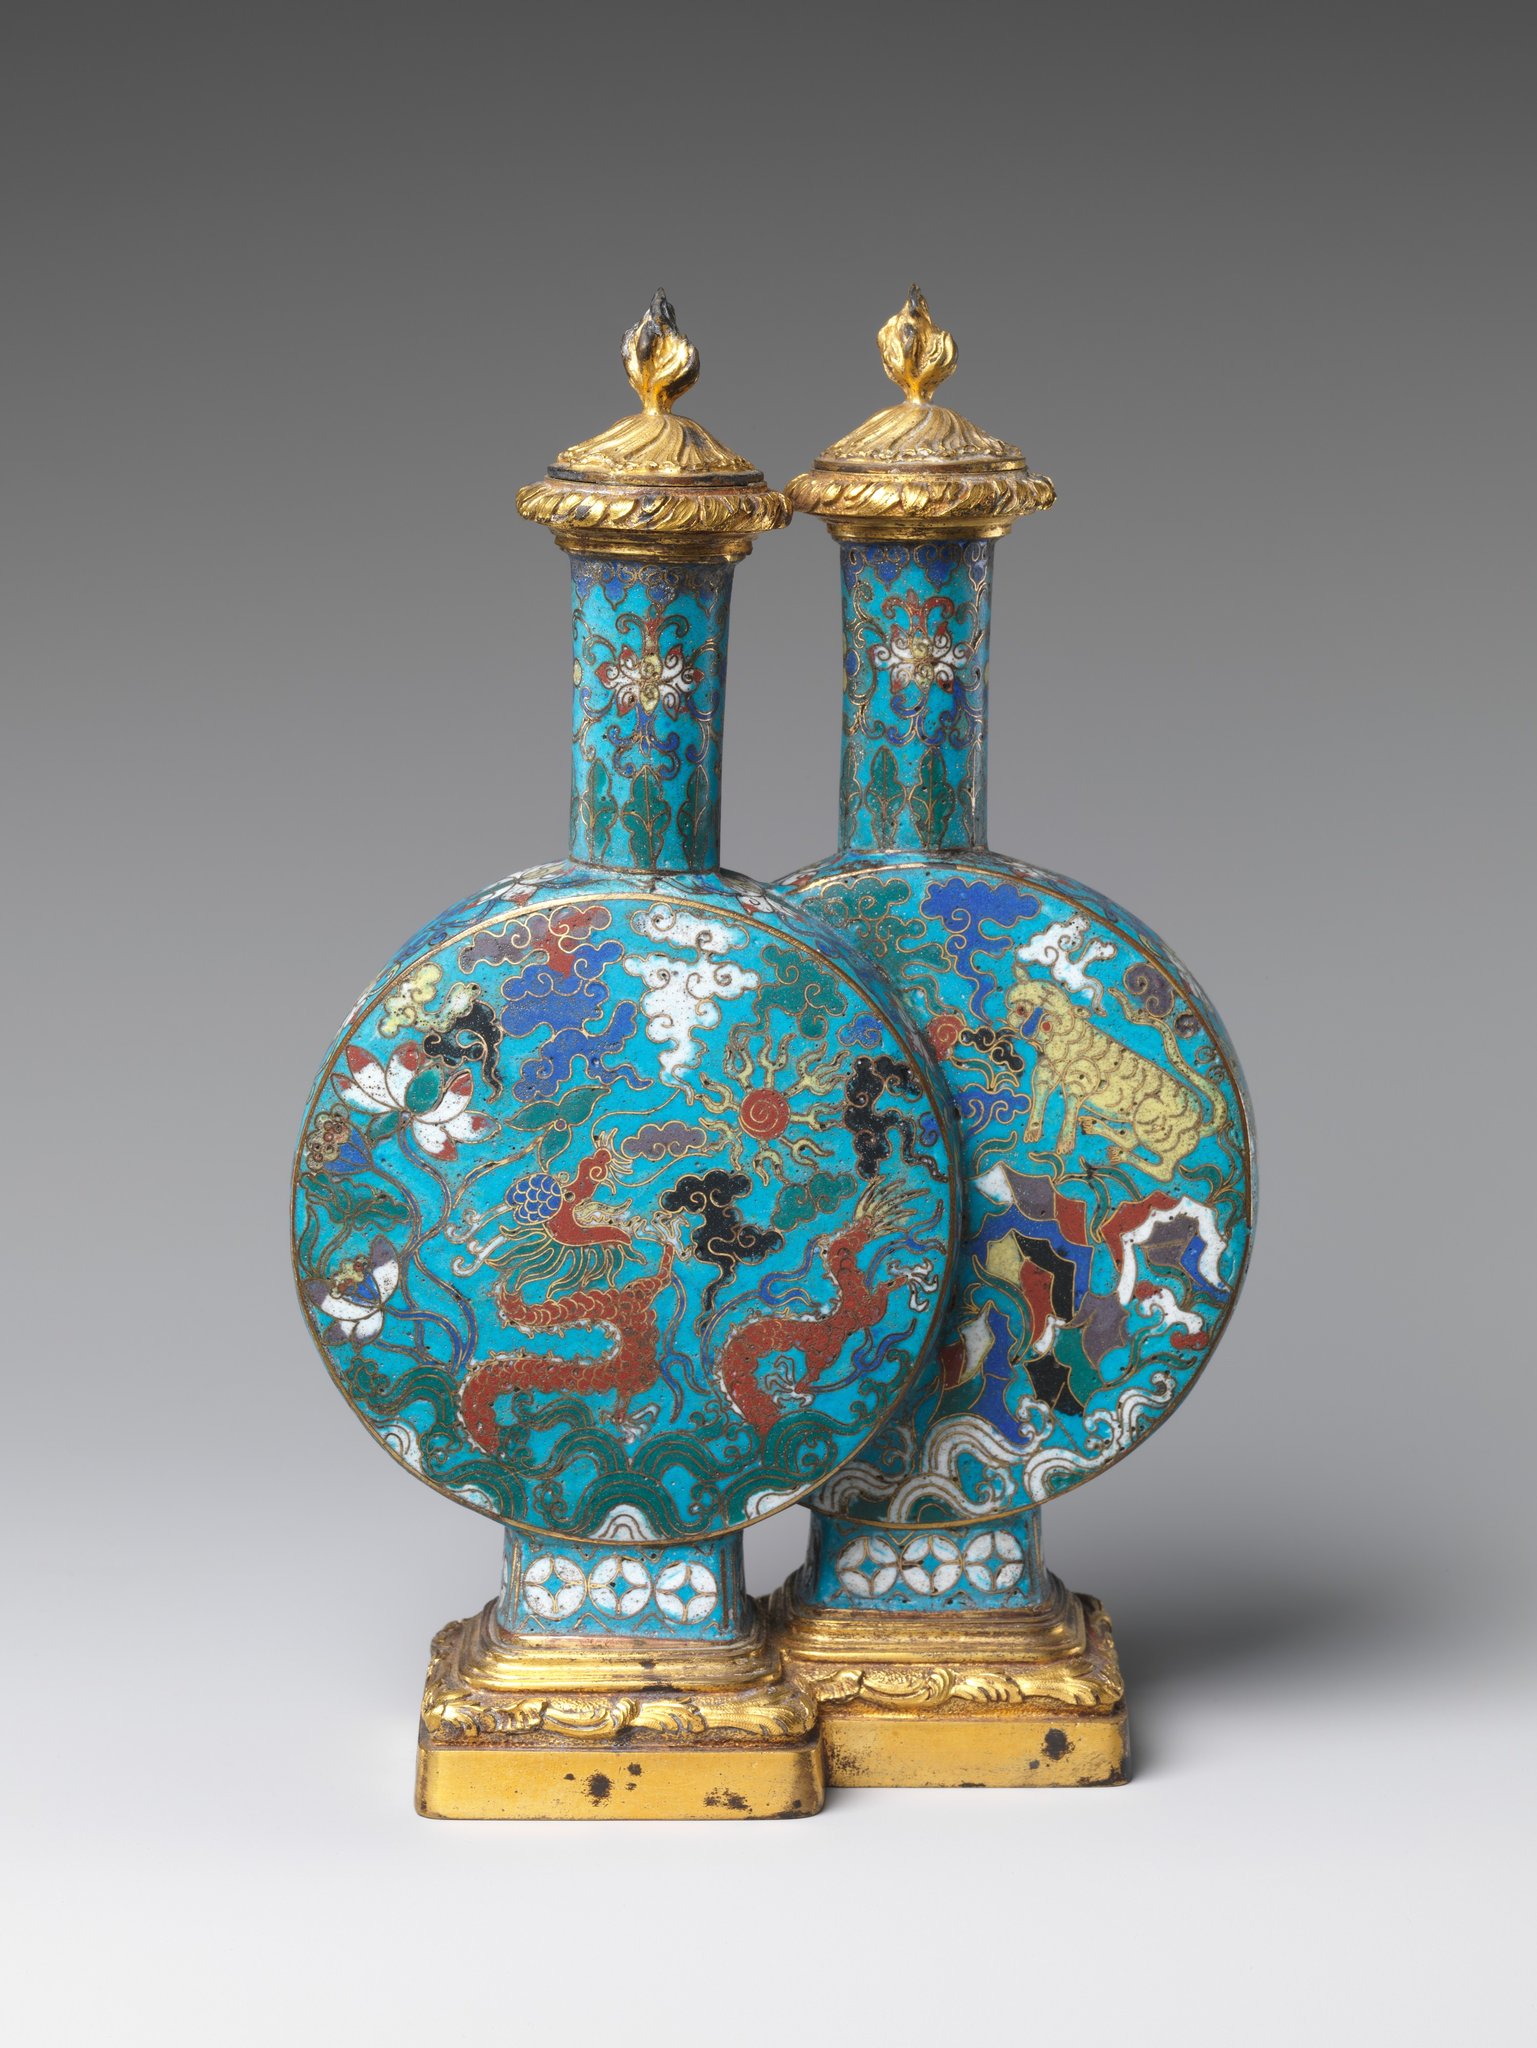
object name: double bottle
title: Double bottle (one of a pair)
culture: chinese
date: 1751-1800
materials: enamel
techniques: enamel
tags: animals,dragons,flowers